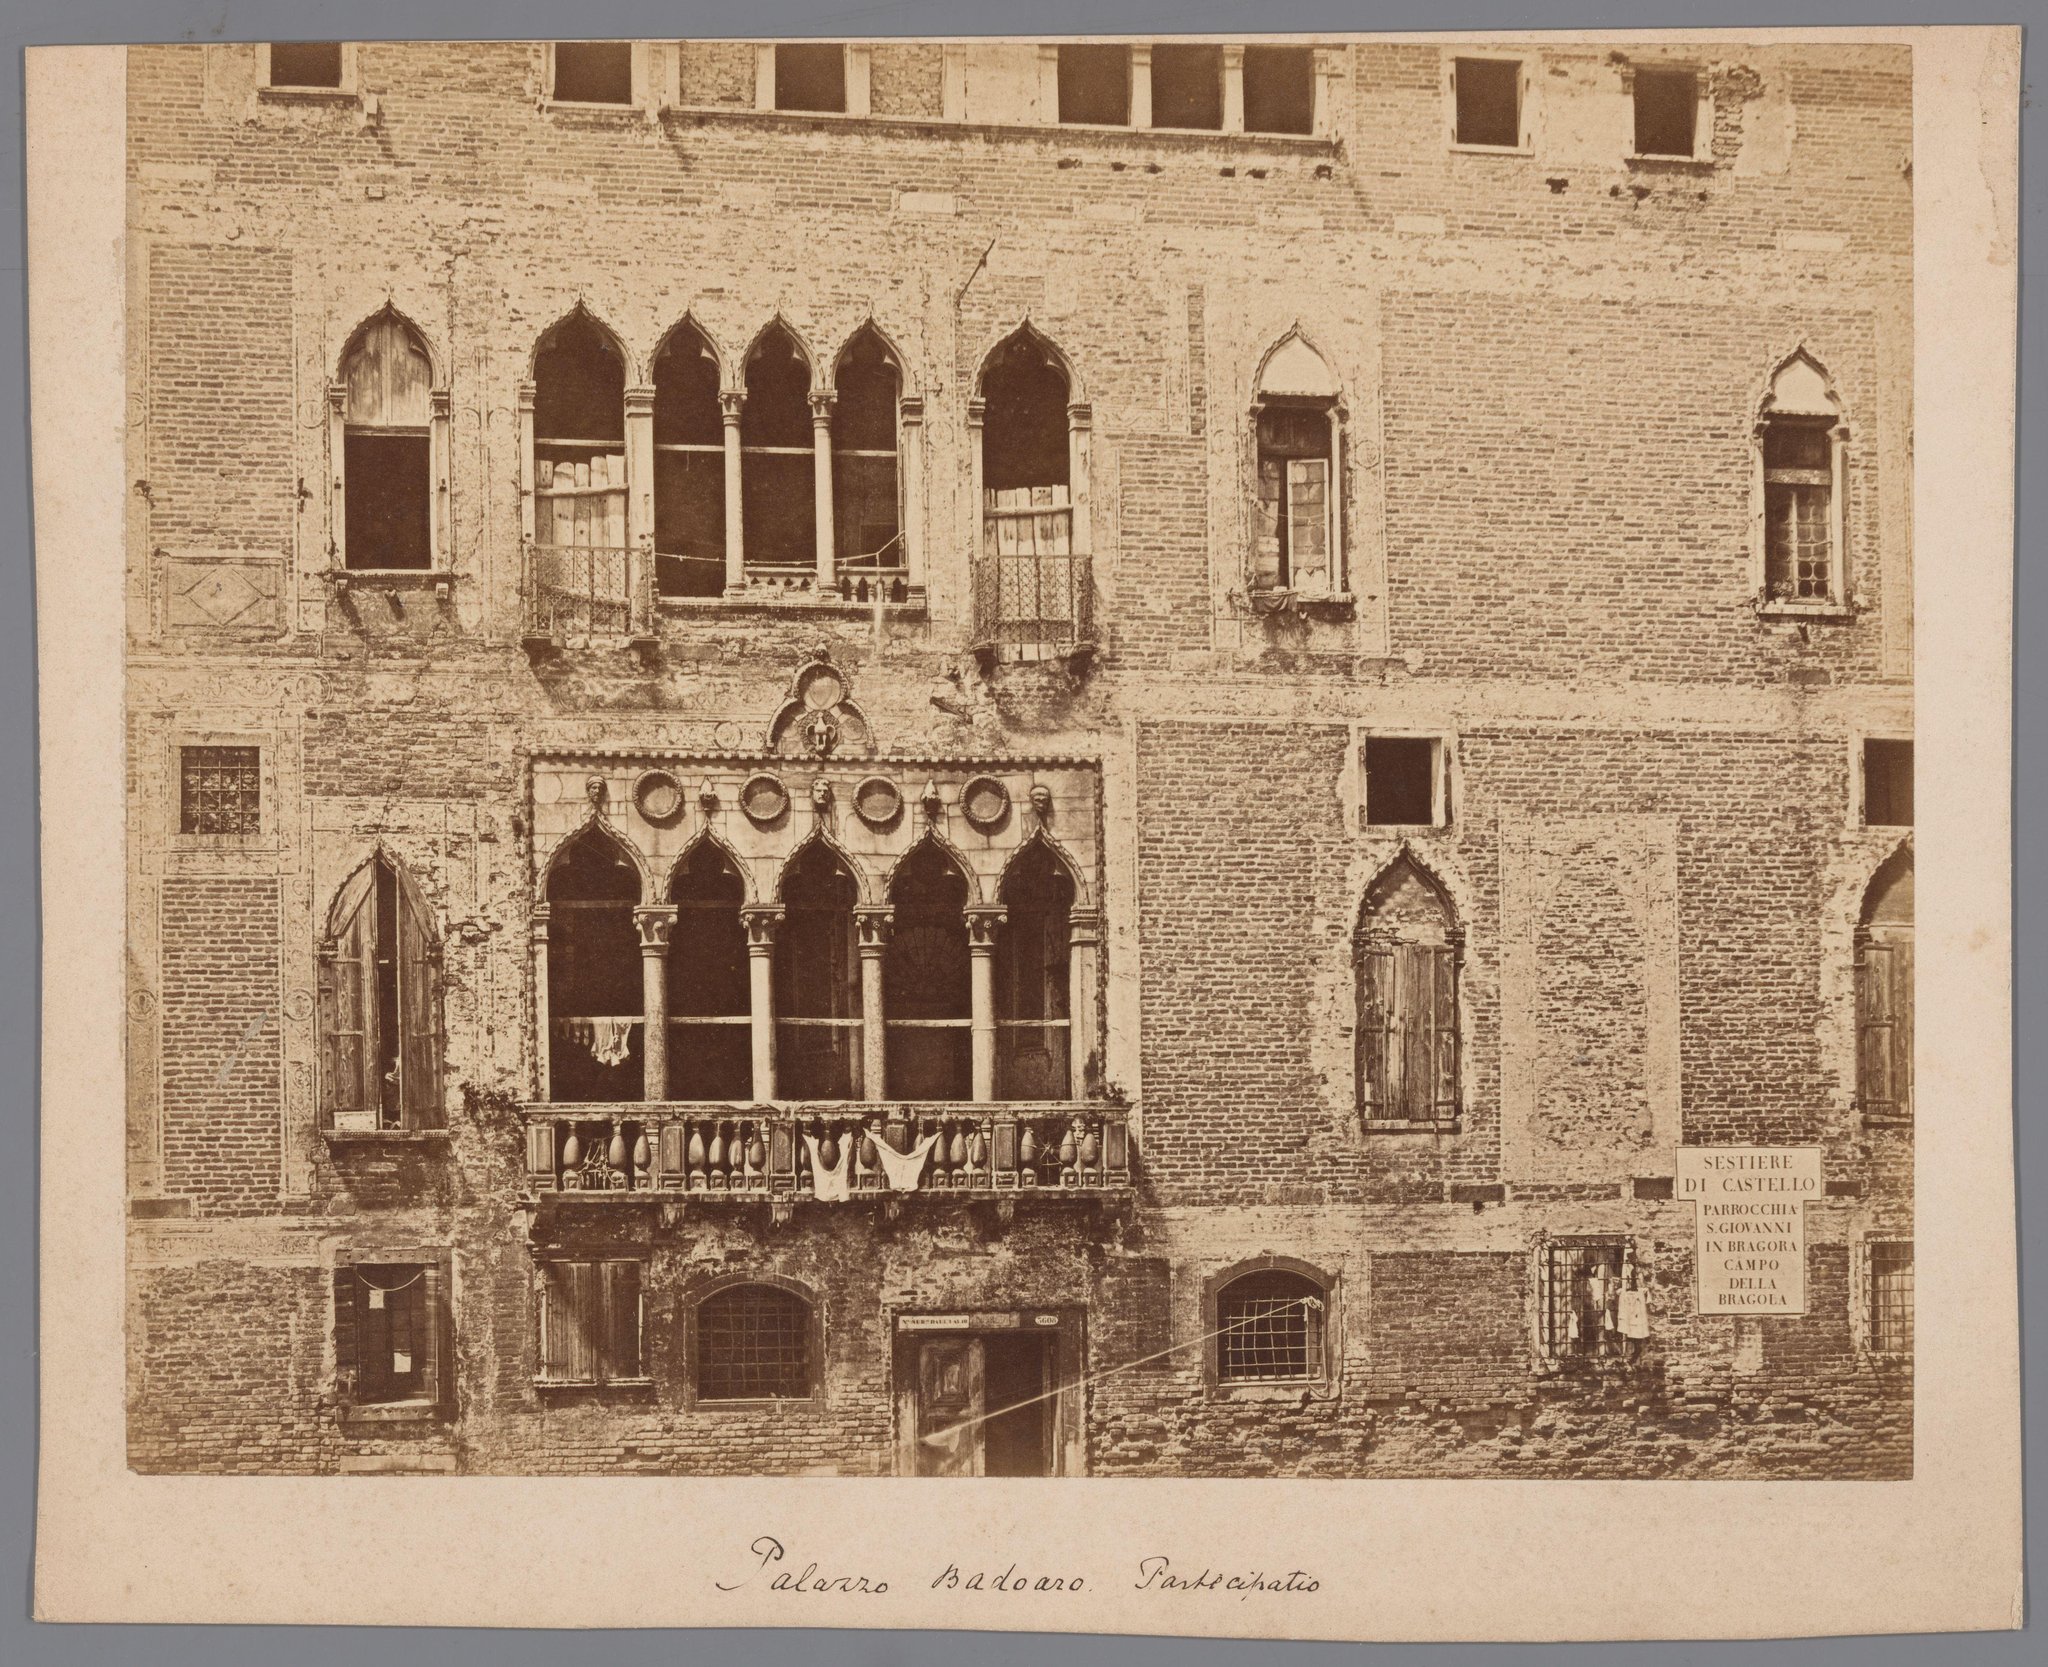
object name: photograph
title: Palazzo Badoaro Partecipatio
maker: Anonymous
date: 1851-1900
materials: cardboard, paper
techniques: albumen print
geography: venice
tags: parts of church exterior and annexes: façade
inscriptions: inscription: ‘SESTIERE/ DI CASTELLO/ PARROCCHIA/ S> GIOVANNI/ IN BRAGORA/ CAMPO/ DELLA/ BRAGOLA’